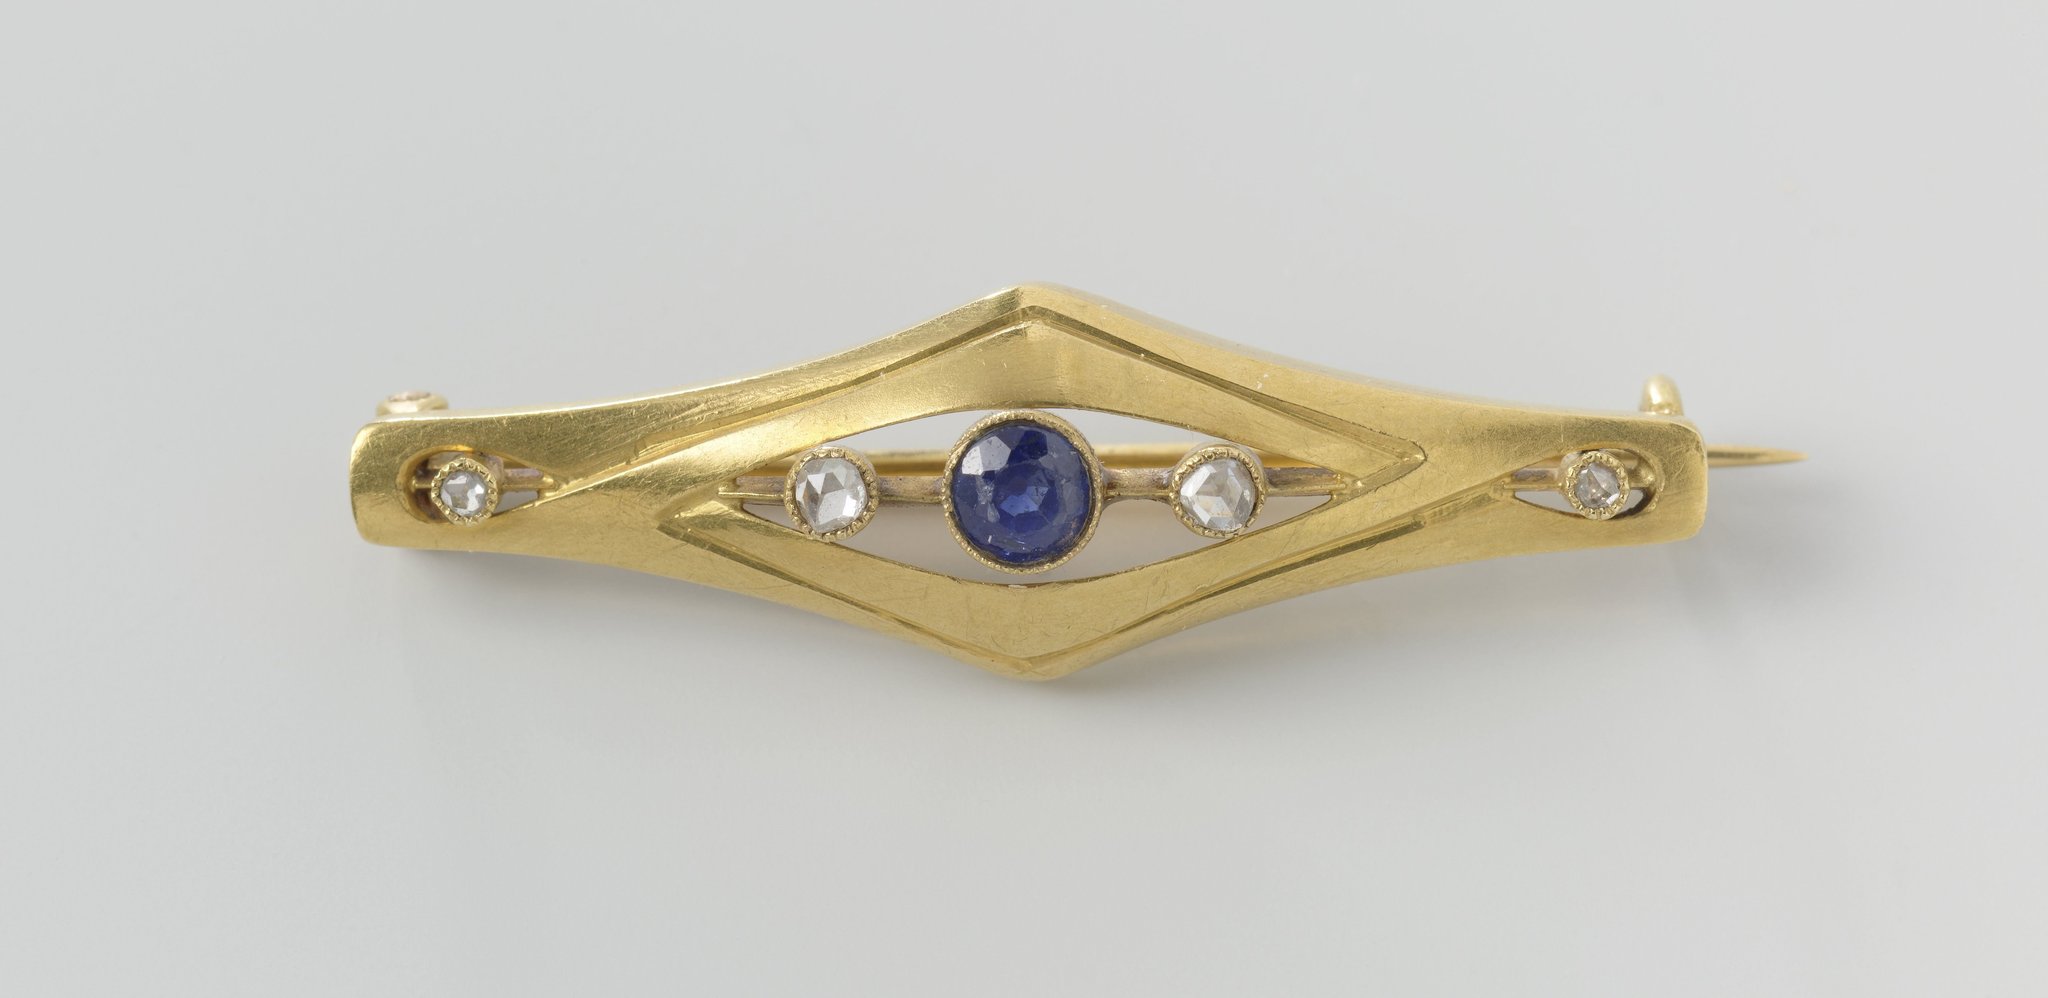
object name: jewellery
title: Broche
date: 1908-1911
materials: diamond, gold, gemstone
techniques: enameling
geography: amsterdam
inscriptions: alloy mark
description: Jewellery. Gold, silver, enamel and semi-precious stones. Amsterdam, c. 1908 - 1911, by L.W. van Kooten, designed by Bert Nienhuis. Given by the Prins Bernhard Fonds, 1980.